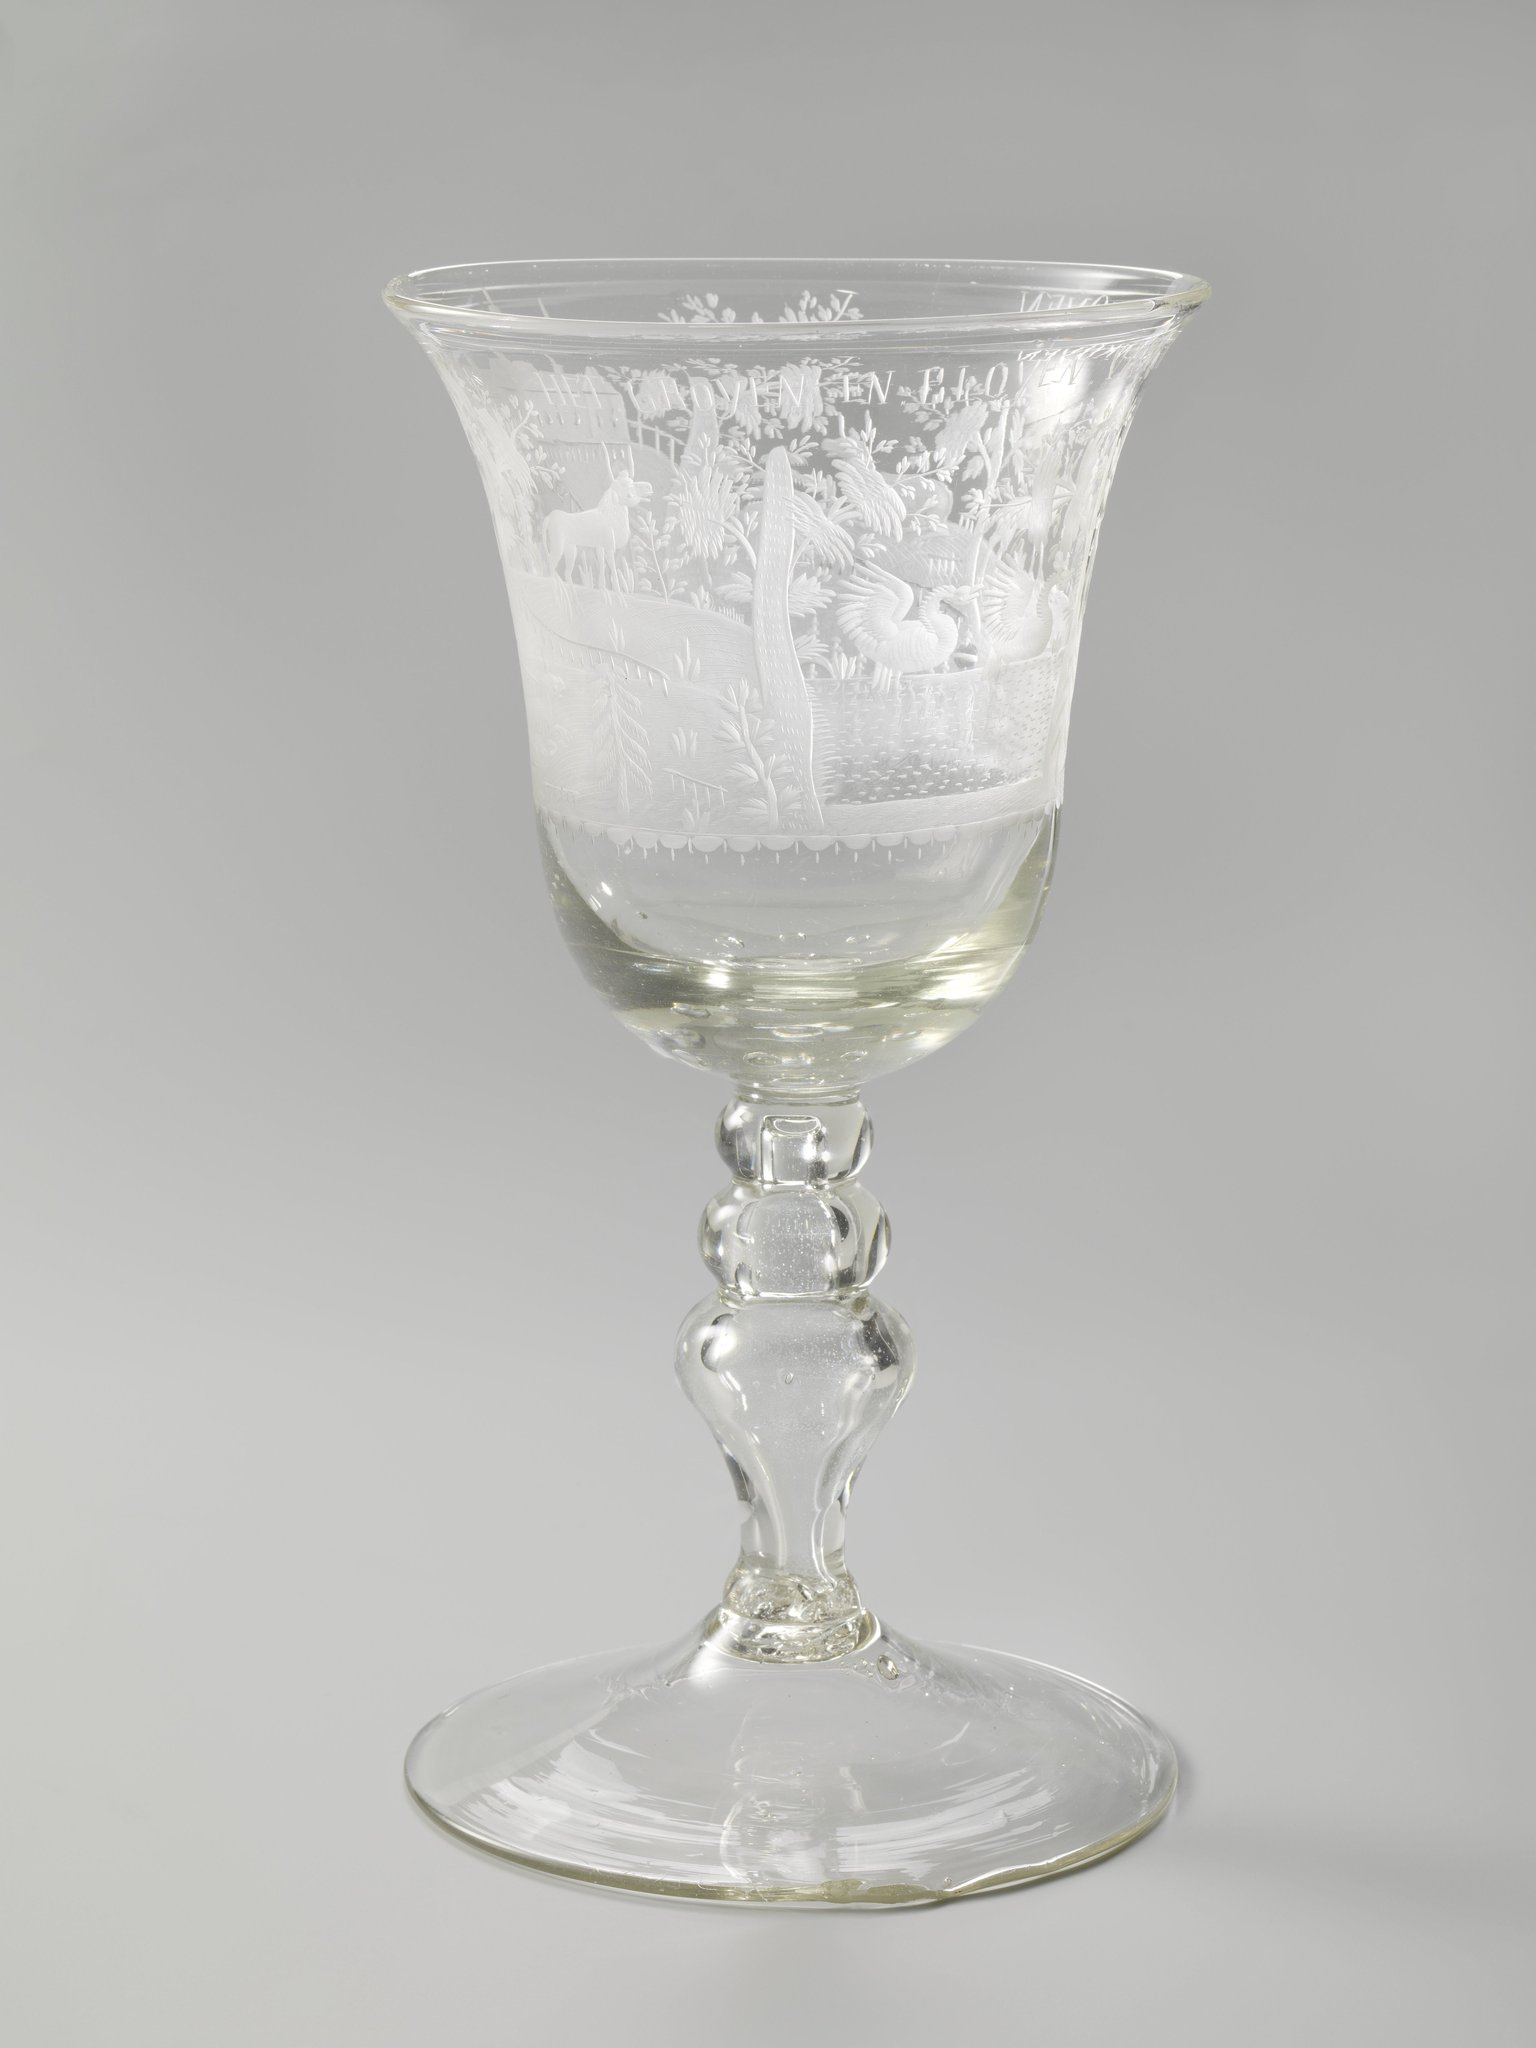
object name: goblet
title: Wine glass with a farm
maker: Anonymous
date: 1725-1750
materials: glass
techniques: glassblowing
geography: germany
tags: farm or solitary house in landscape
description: translation of inscription: The Growing and Flourishing of Oxen and Cows